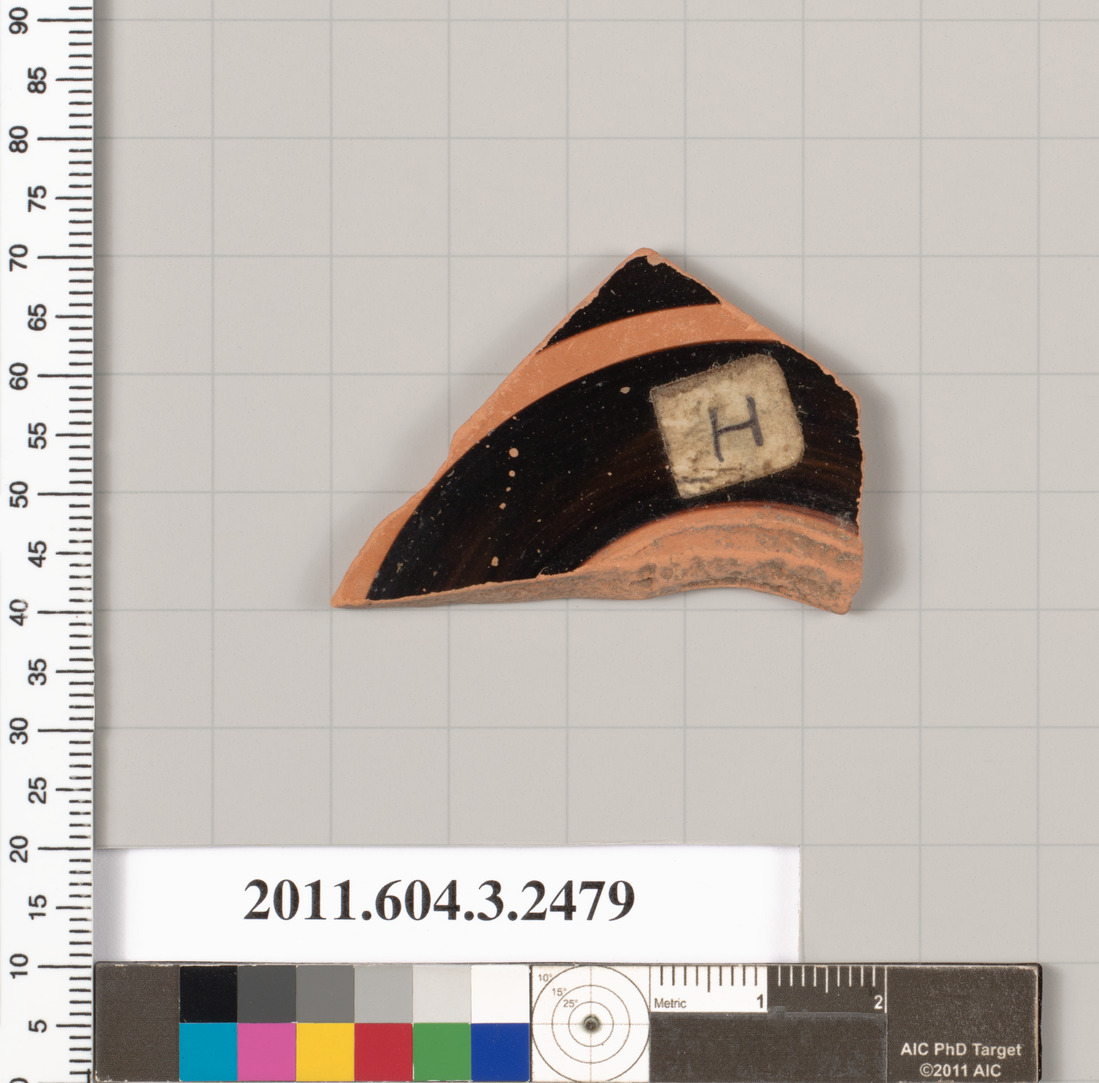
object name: kylix fragment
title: Terracotta fragment of a kylix (drinking cup)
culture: greek, attic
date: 600-401 BCE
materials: terracotta